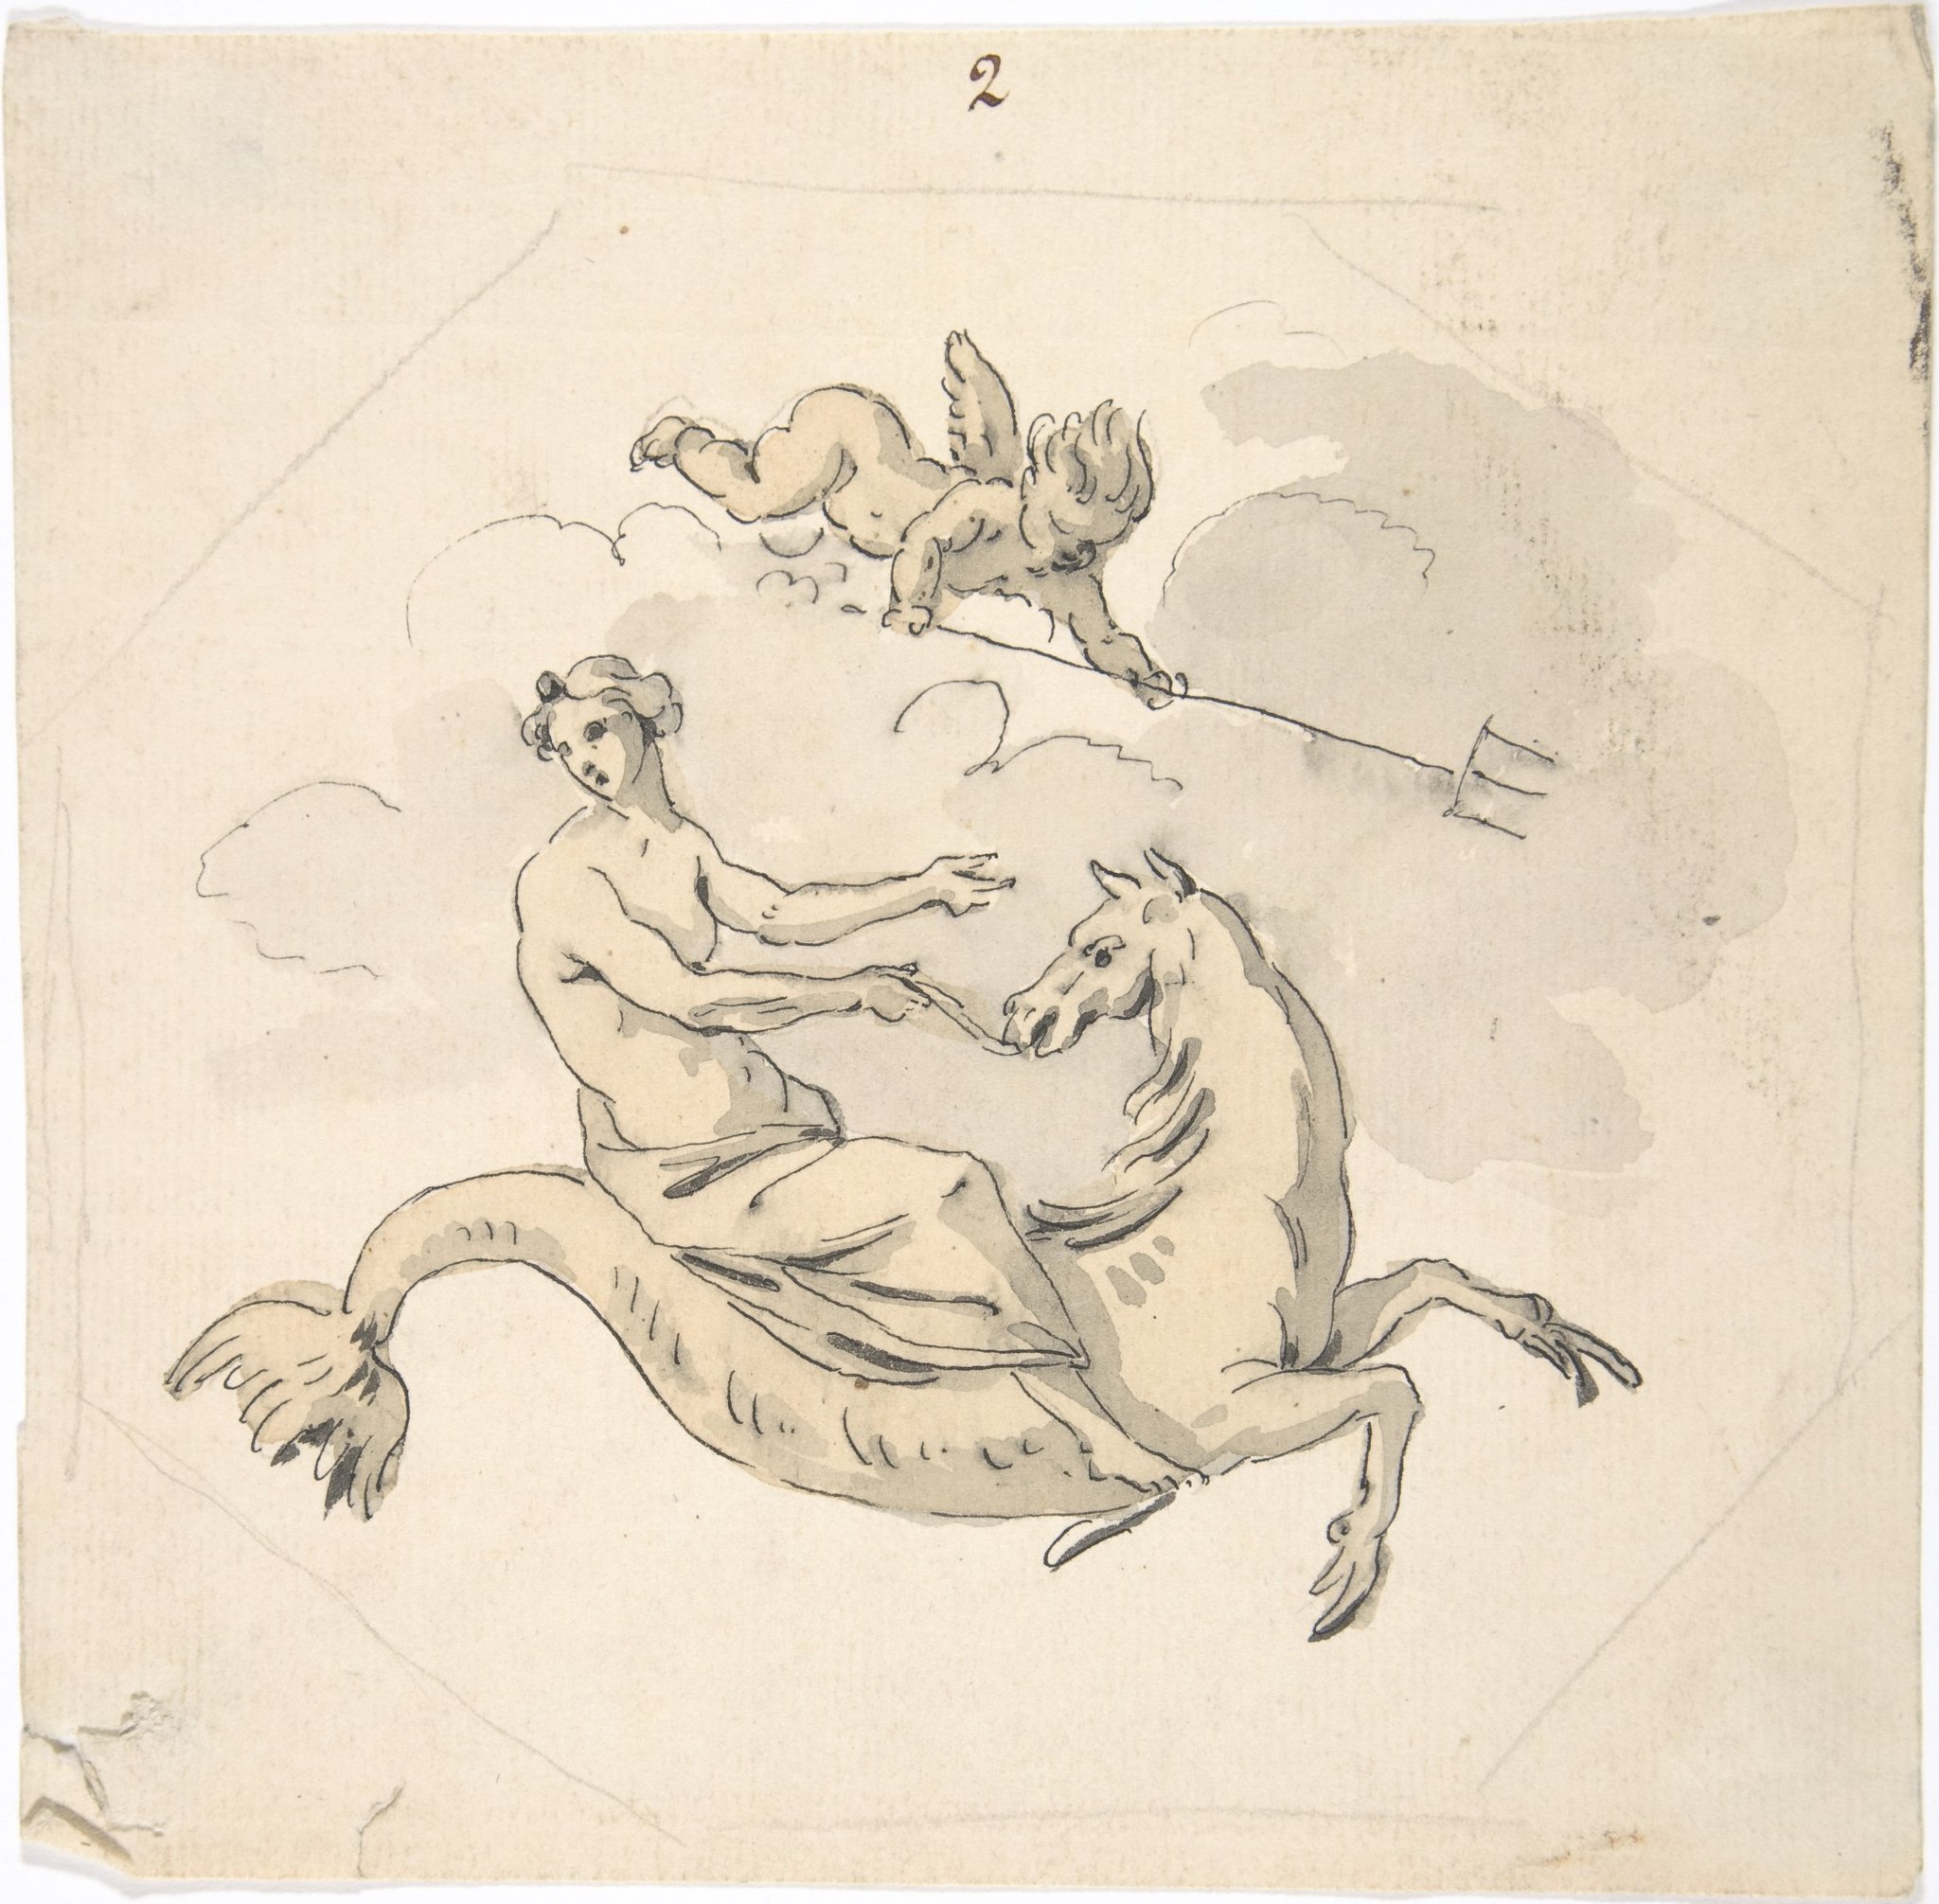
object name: drawing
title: Ceiling Design of a Nereid Mounted on a Hippocamp with Putto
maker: anonymous, french, 18th century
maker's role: artist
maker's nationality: french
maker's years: 1700-1800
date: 1701-1800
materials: graphite, ink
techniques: brush, pen, wash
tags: putti,hippocamps